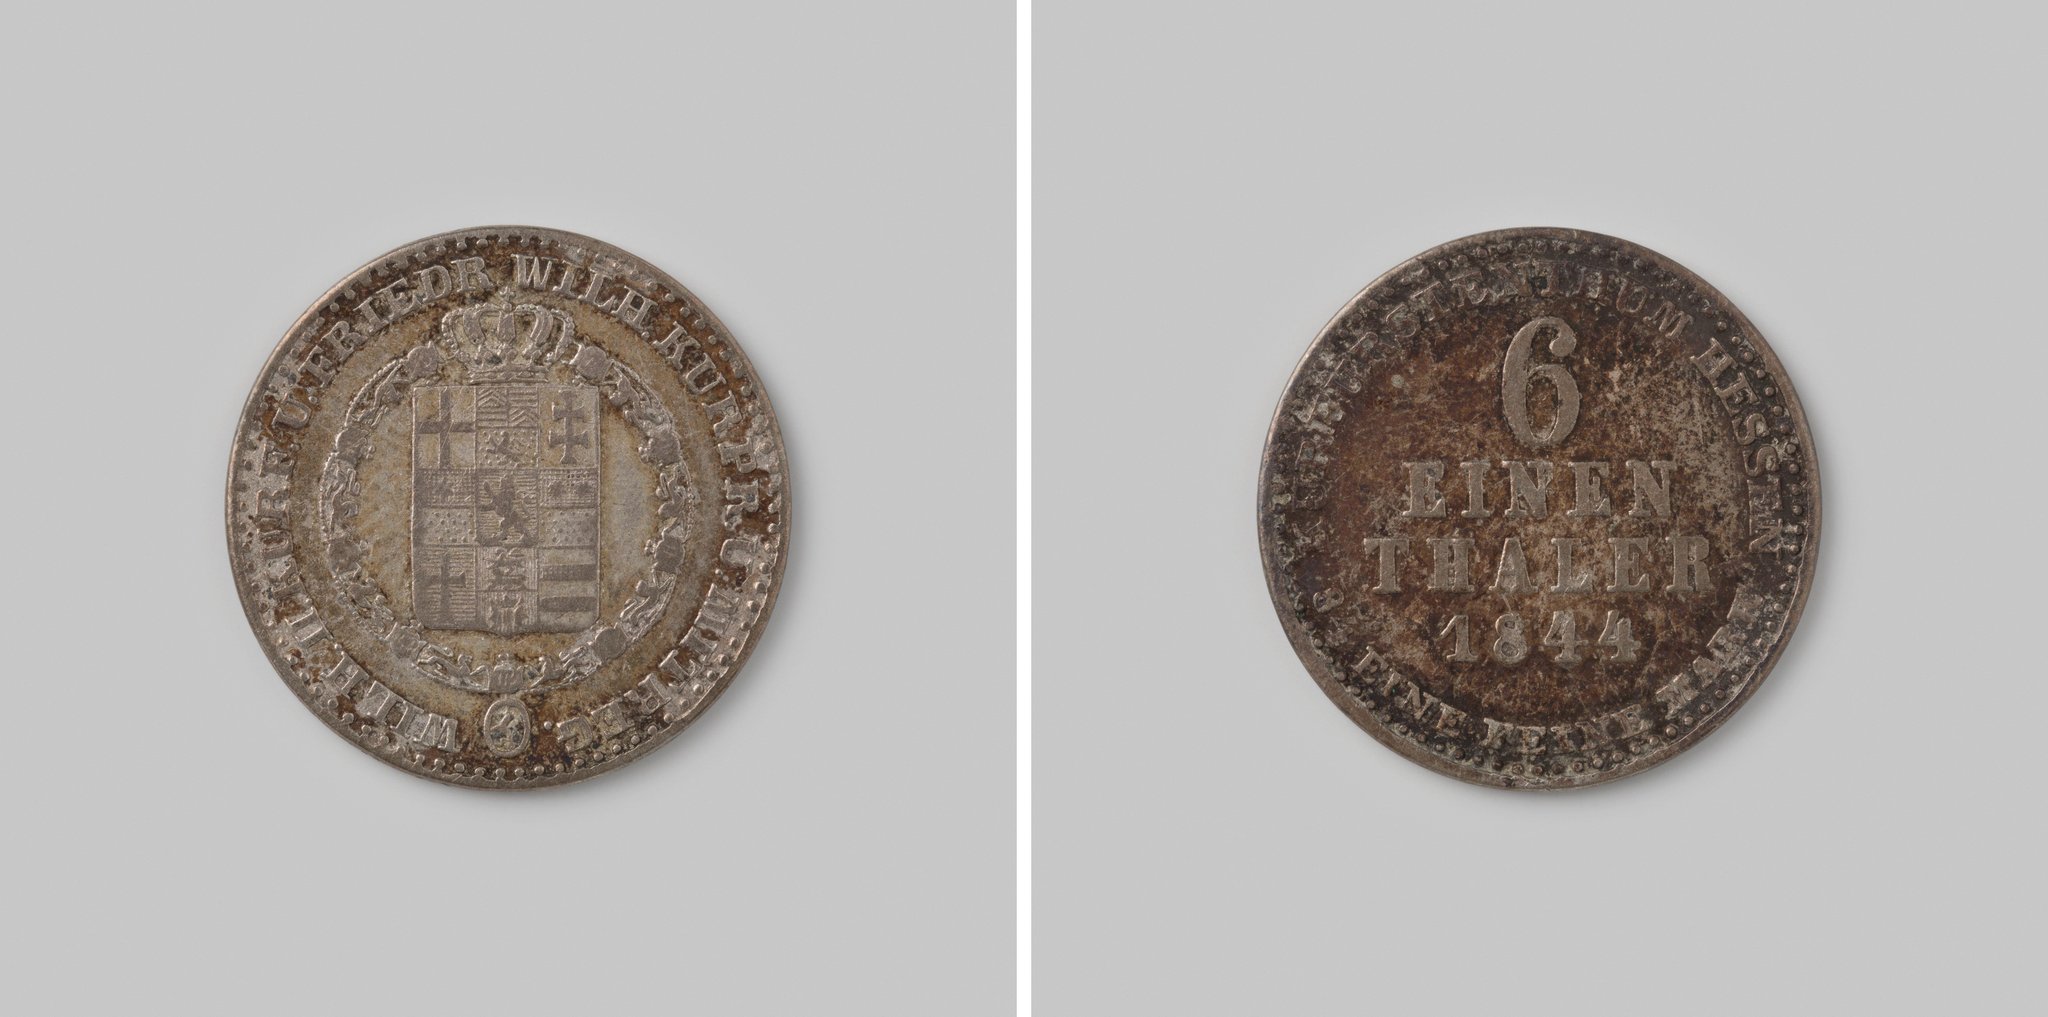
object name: zesde taler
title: Kerurvorstendom Hessen-Kassel, Wilhelm II met Friedrich Wilhelm als regent, 1/6 taler, 1844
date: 1844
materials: silver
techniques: striking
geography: kassel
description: Zilveren munt. Voorzijde: met een ridderorde omhangen gekroond samengesteld wapenschild. Keerzijde: waarde-aanduiding in drie regels,waaronder jaartal. Randschrift.